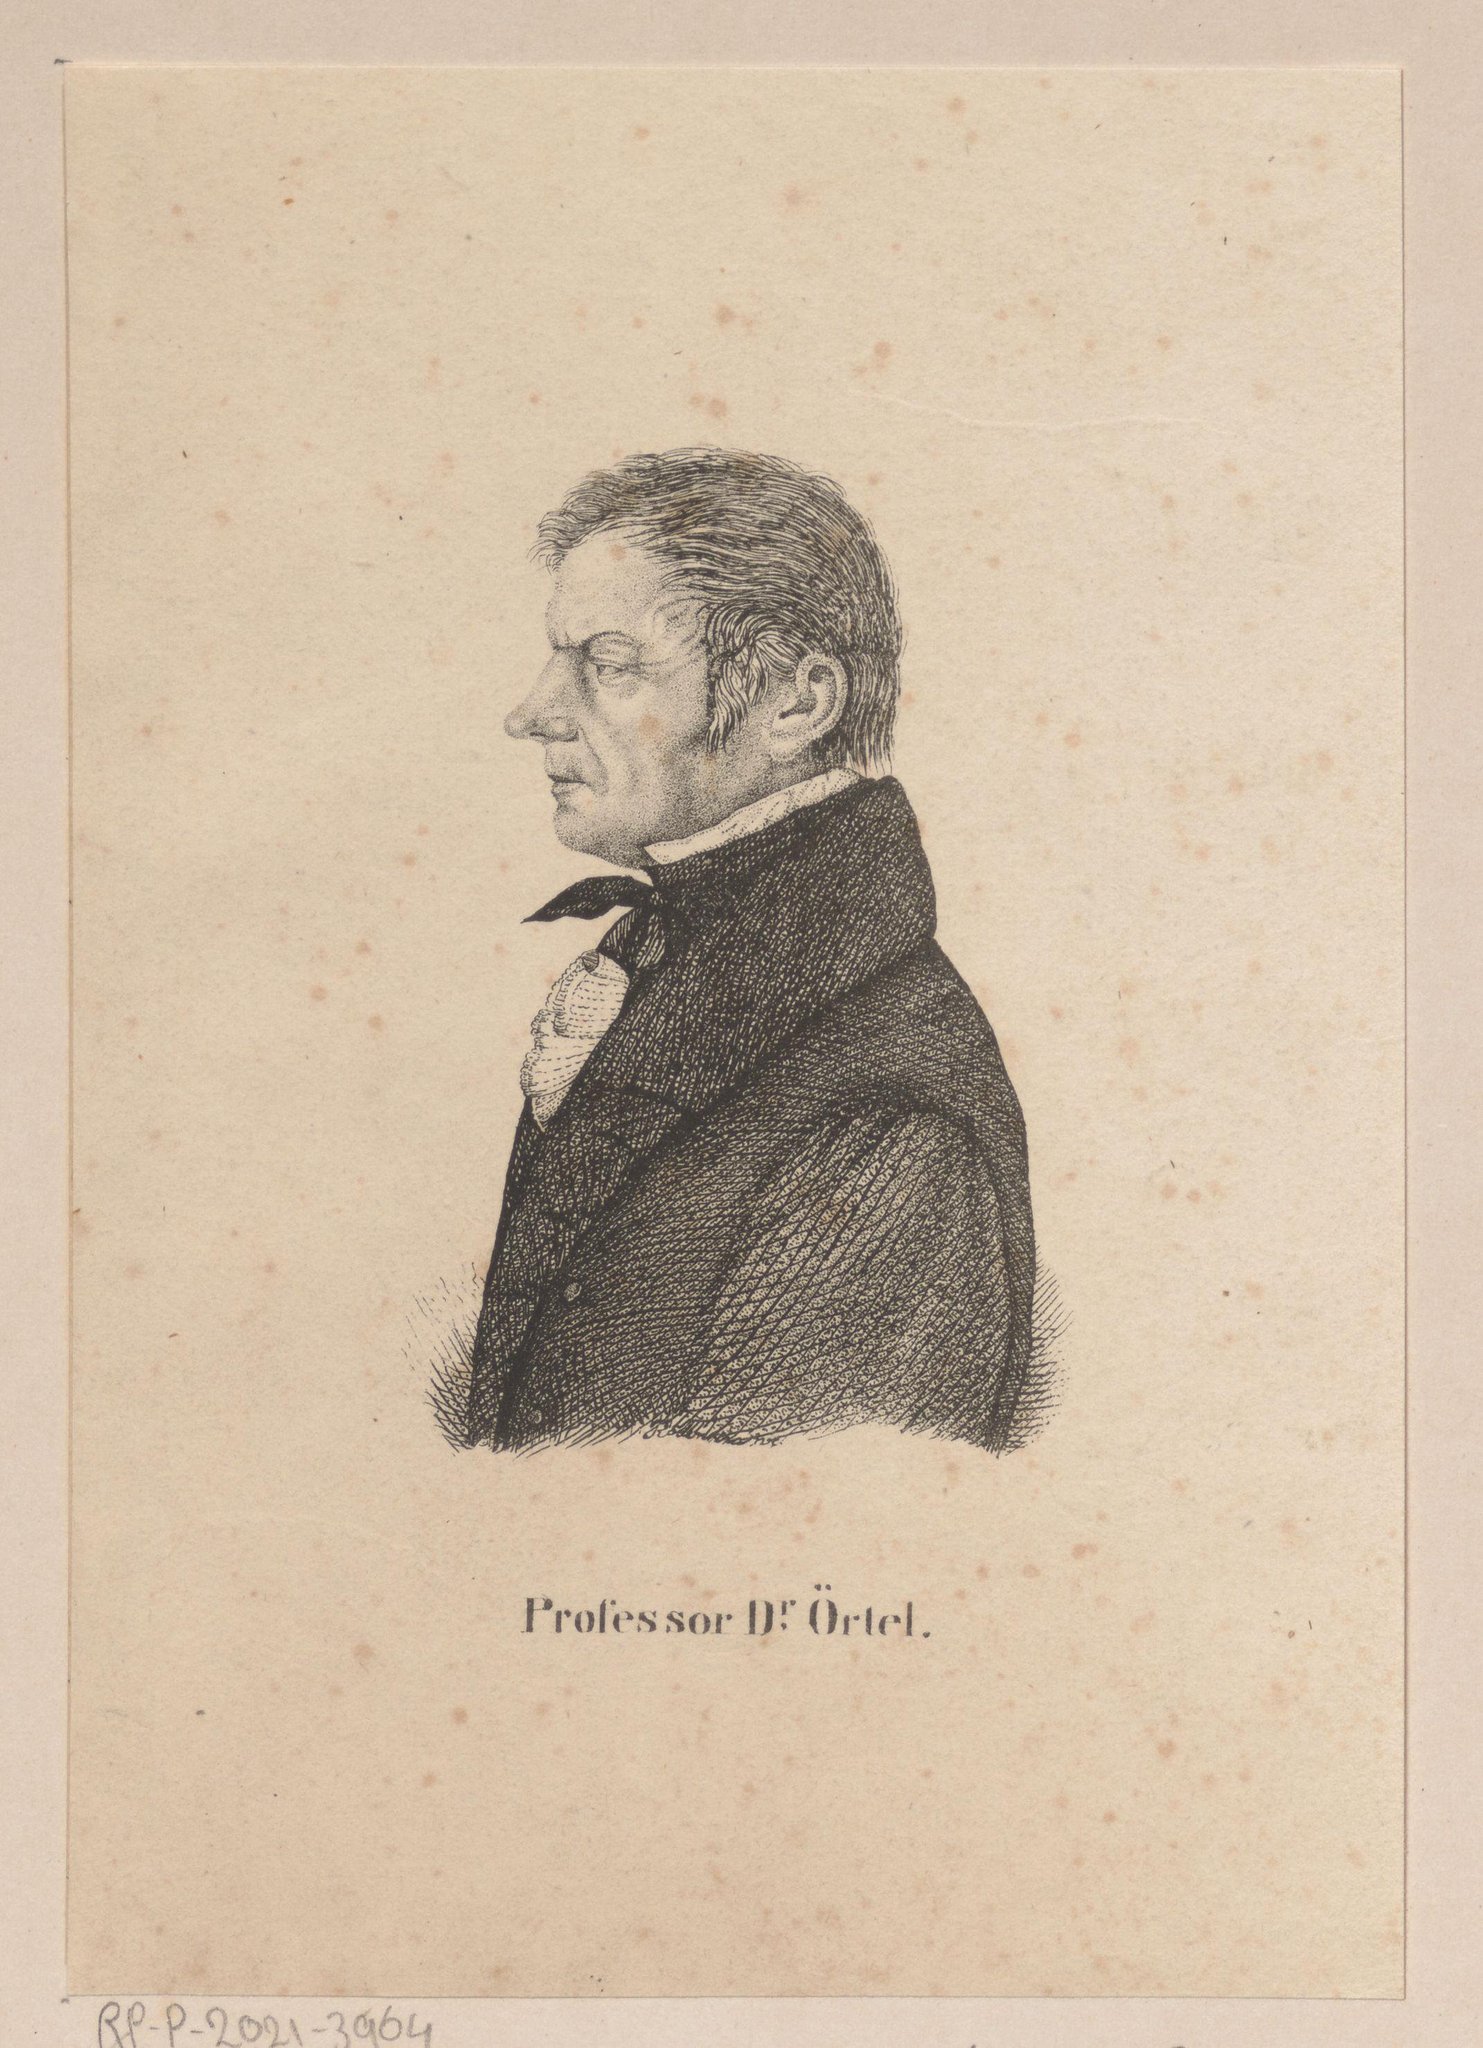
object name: print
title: Portret van Eucharius Ferdinand Christian Oertel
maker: Anonymous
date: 1795-1899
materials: paper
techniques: lithograph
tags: historical persons, professor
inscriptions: signature: ‘Rozenkranz’